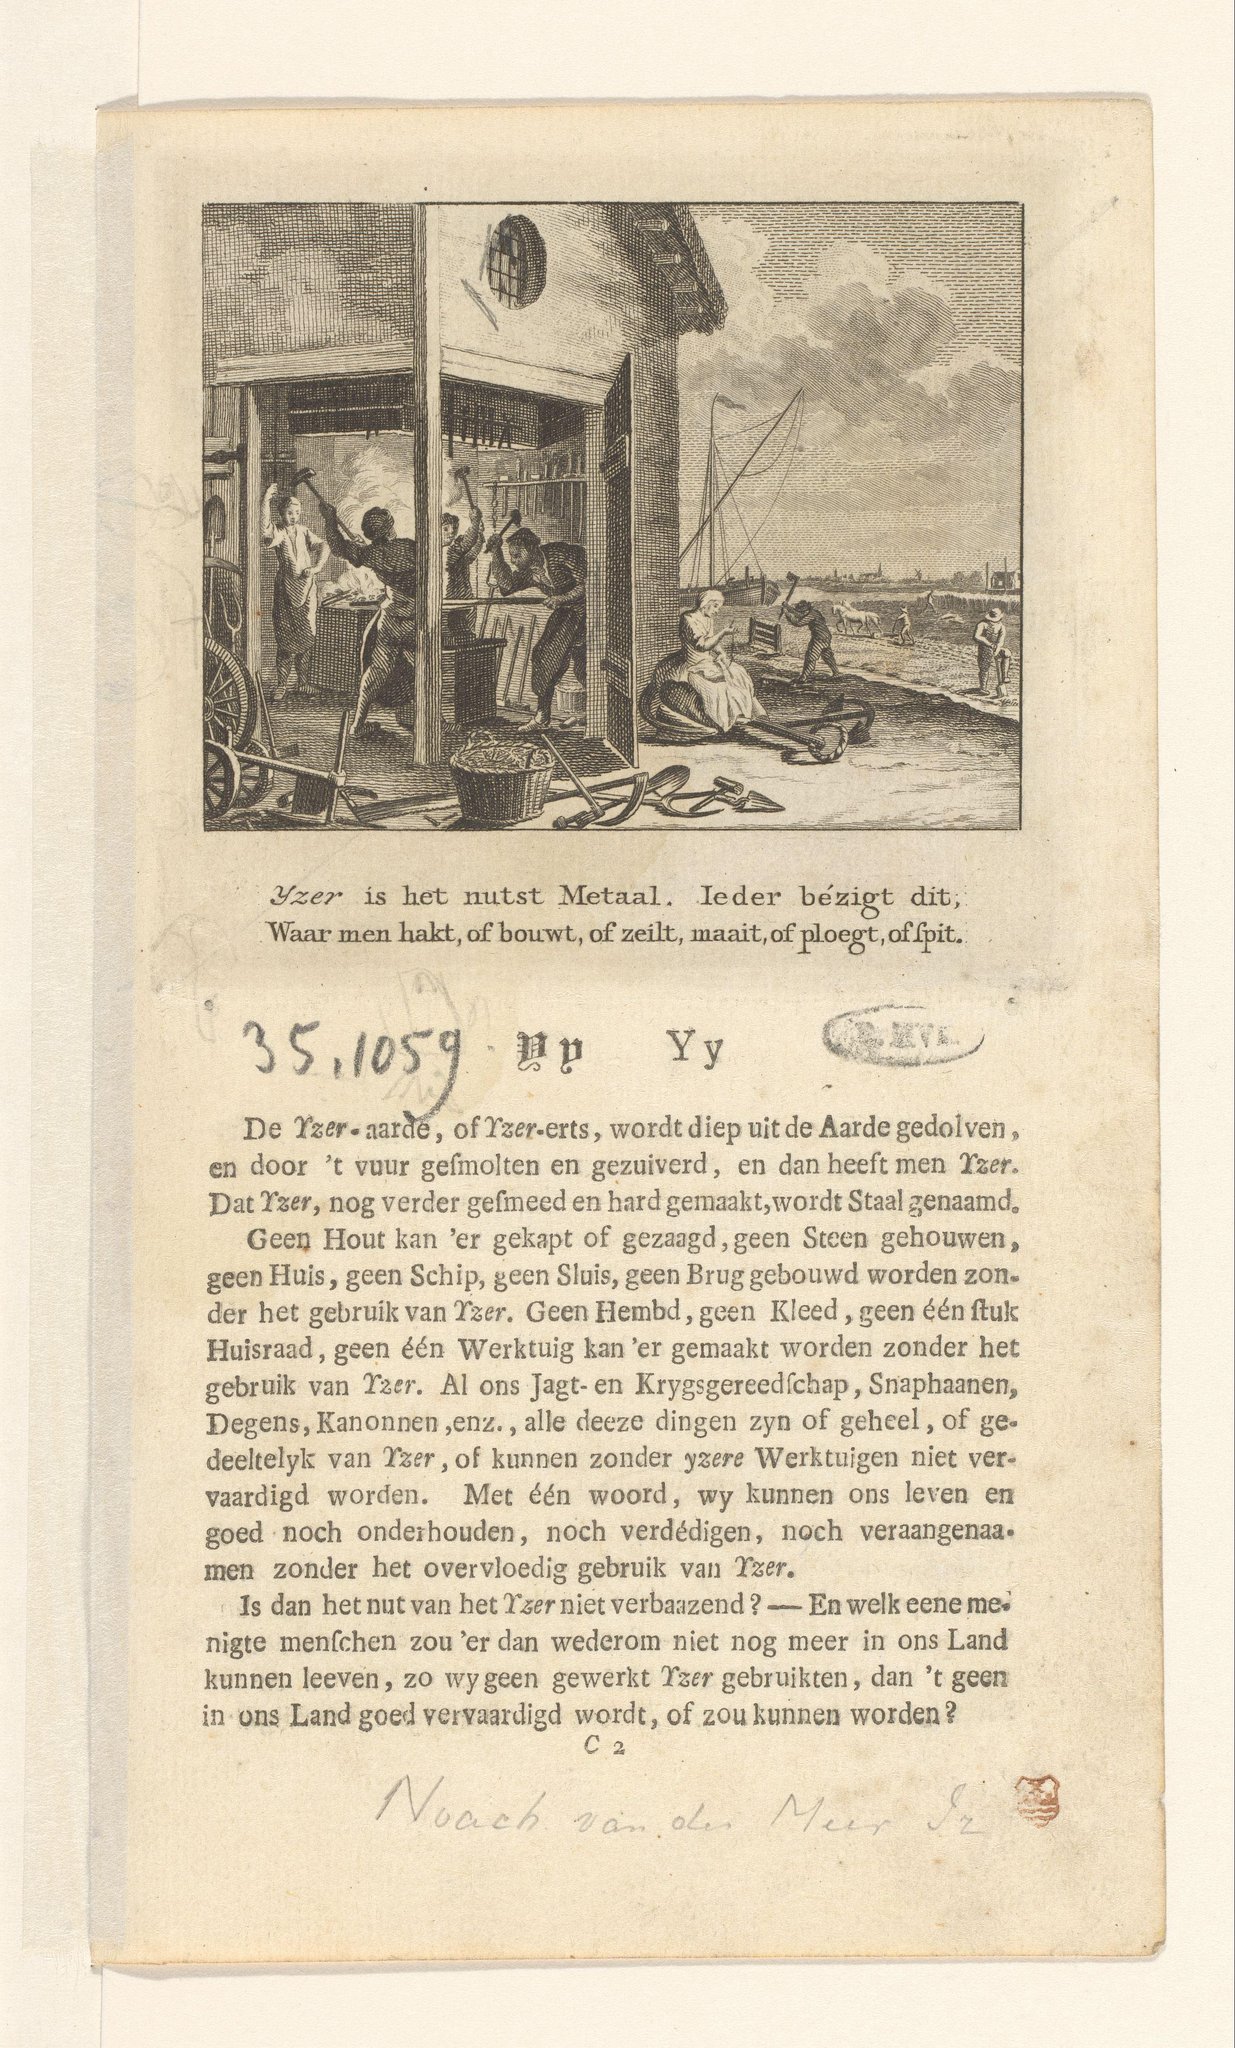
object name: print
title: Bewerken van ijzer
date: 1781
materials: paper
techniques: etching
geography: amsterdam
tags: smith, blacksmith, ploughing, sewing, iron and steel industry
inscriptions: collector's mark: Lugt 2760, collector's mark: Lugt 2228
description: In een open smidse bewerken mannen met hamers het metaal ijzer. Op de voorgrond liggen ijzeren werktuigen en op de achtergrond worden deze gebruikt. Een zittende vrouw naait met een ijzeren naald, een man zet een schop in de grond en een boer ploegt het land met een ploeg. Onderaan een verklarende tekst bij de letter Y.